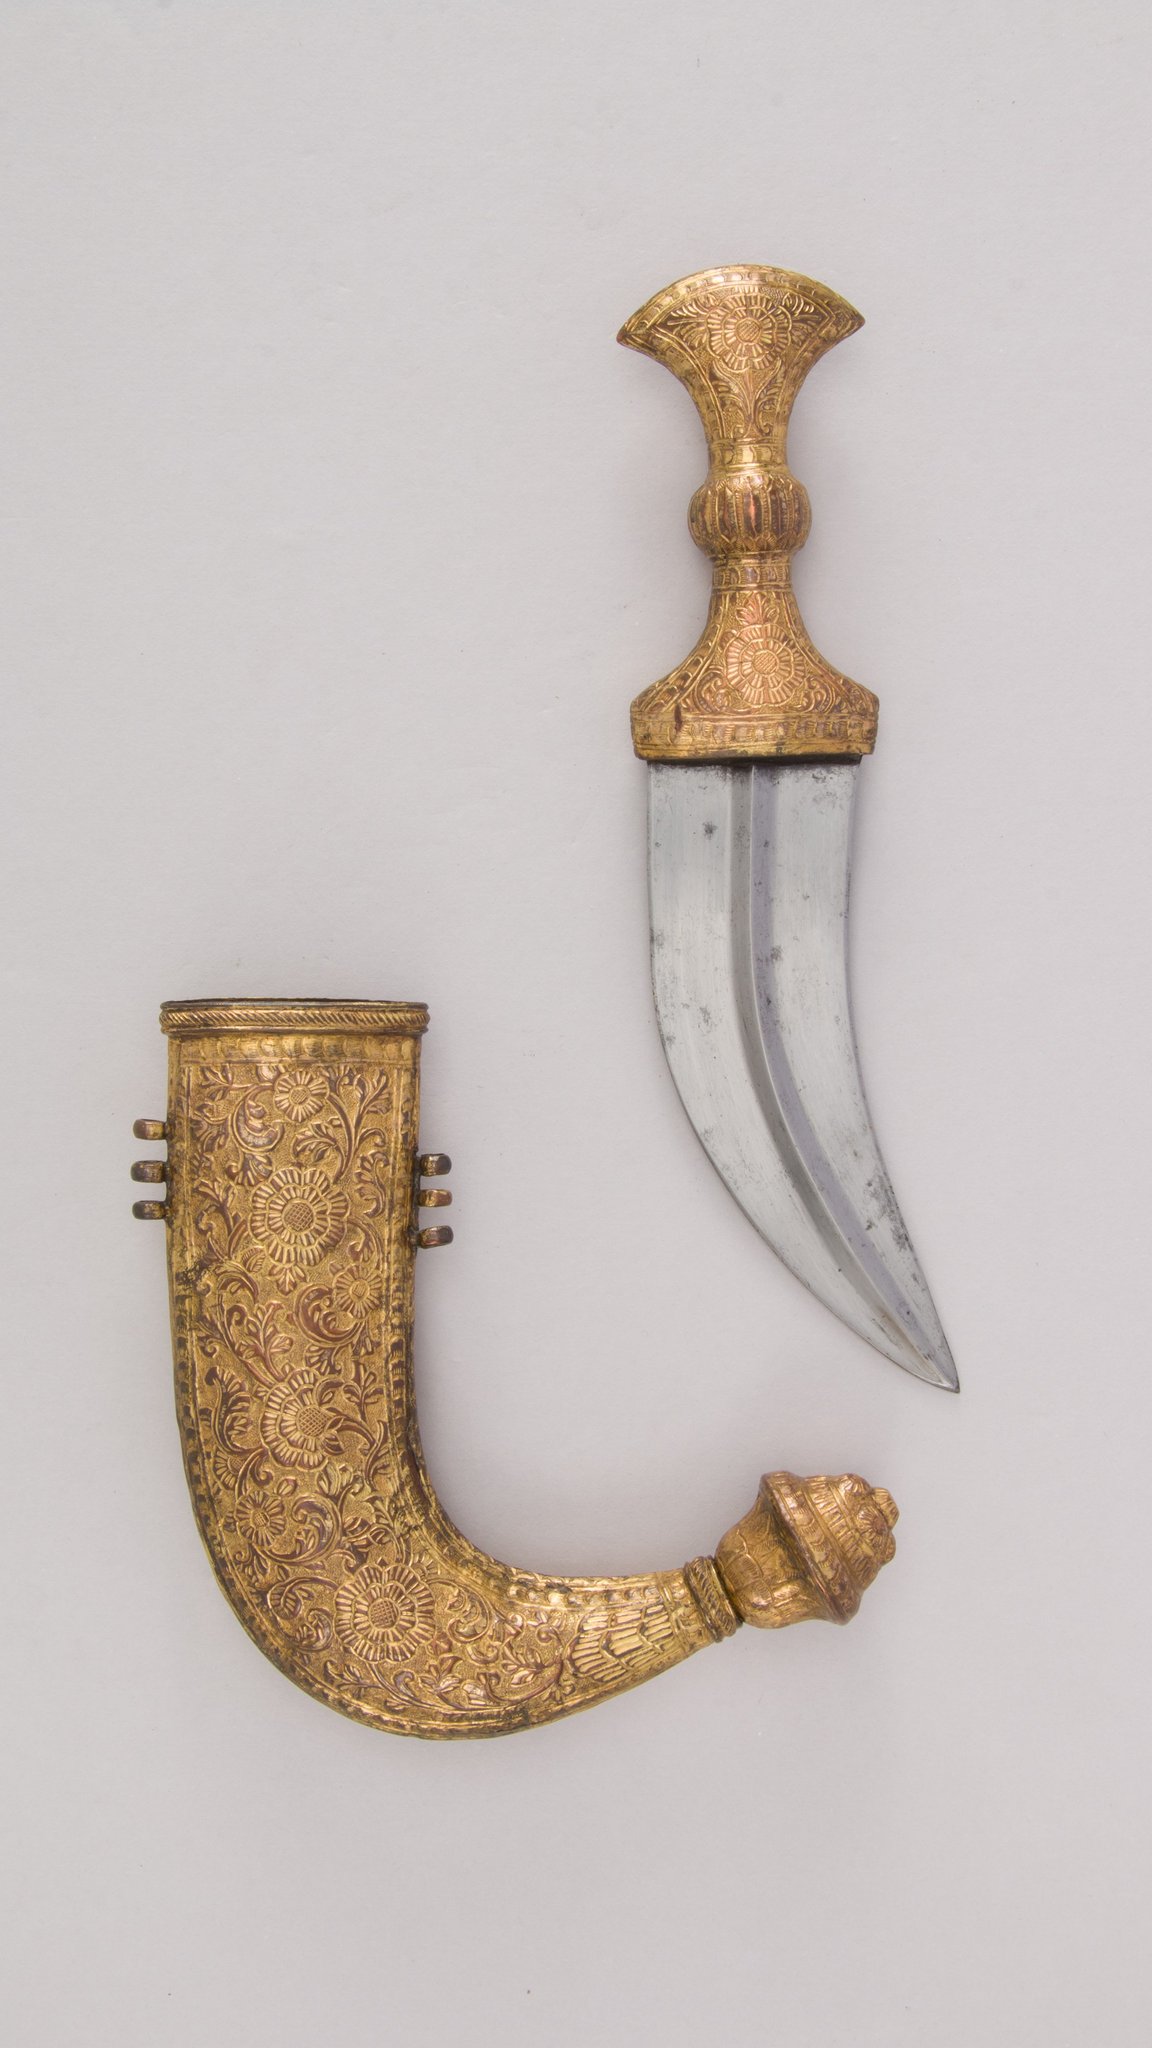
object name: dagger jambiya with sheath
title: Dagger (Jambiya) with Sheath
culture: indian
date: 1801-1900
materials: copper, gold, steel, wood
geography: india